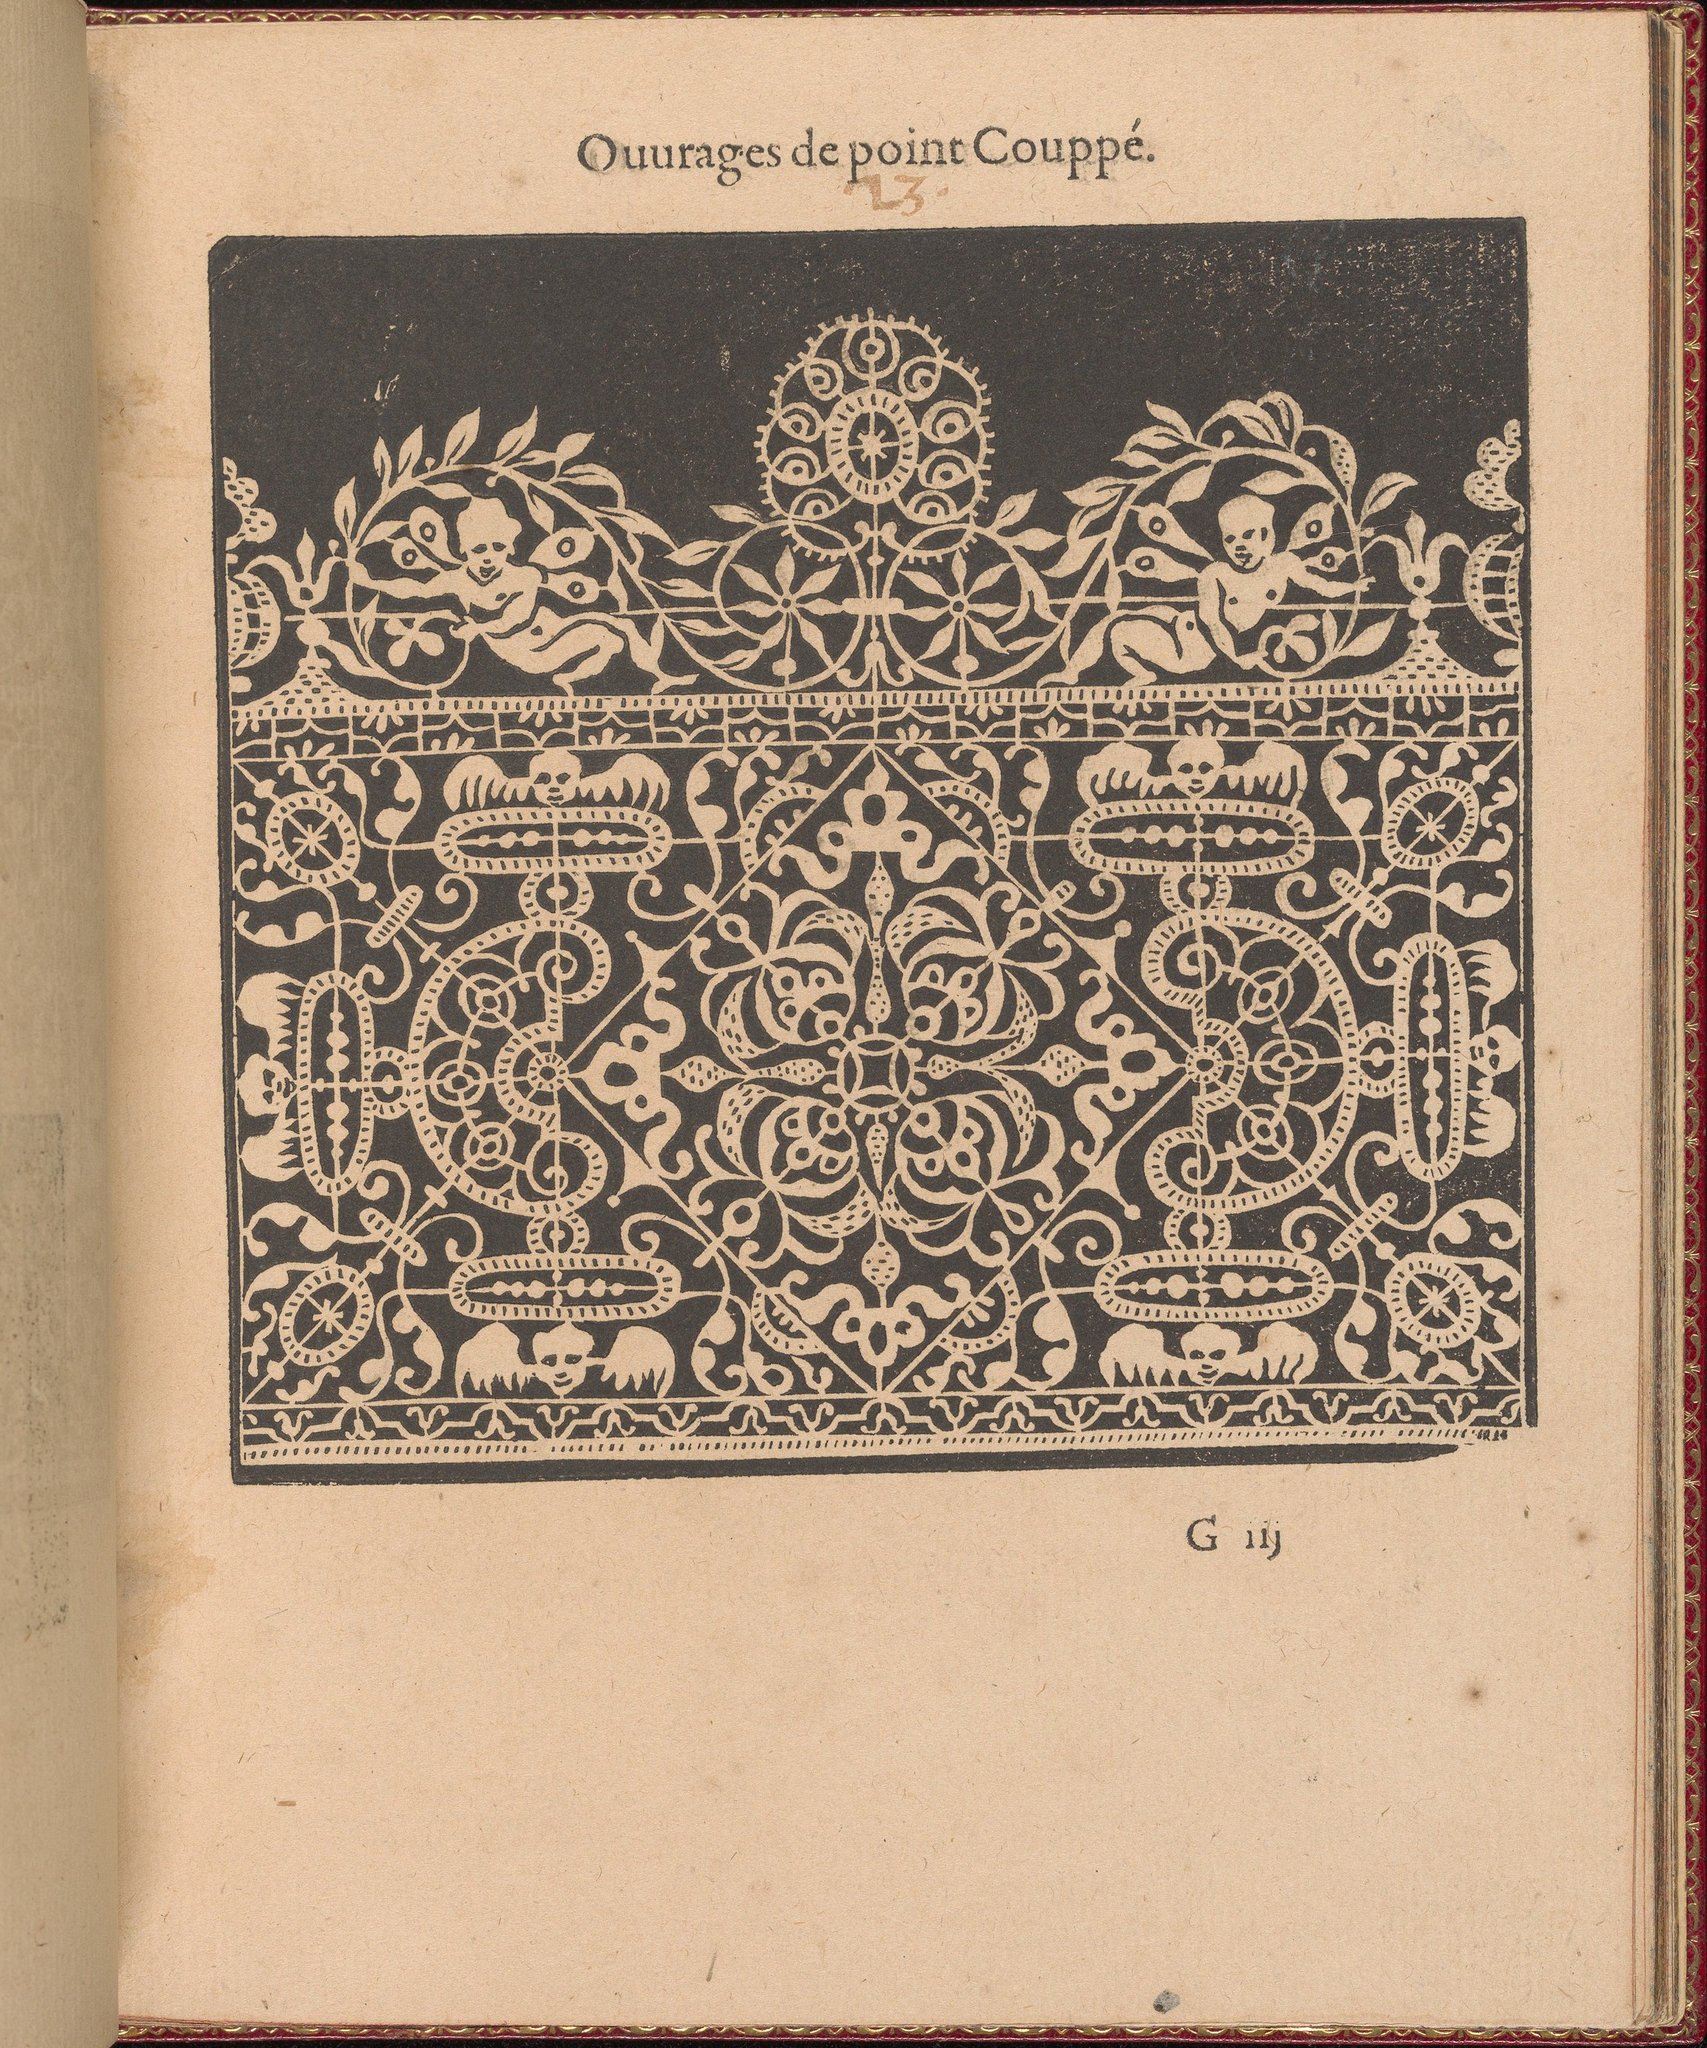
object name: book print ornament architecture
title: Les Singuliers et Nouveaux Portraicts... page 27 (recto)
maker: federico de vinciolo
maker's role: designer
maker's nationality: italian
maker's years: 1582-1599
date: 1588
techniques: woodcut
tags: ornament,putti